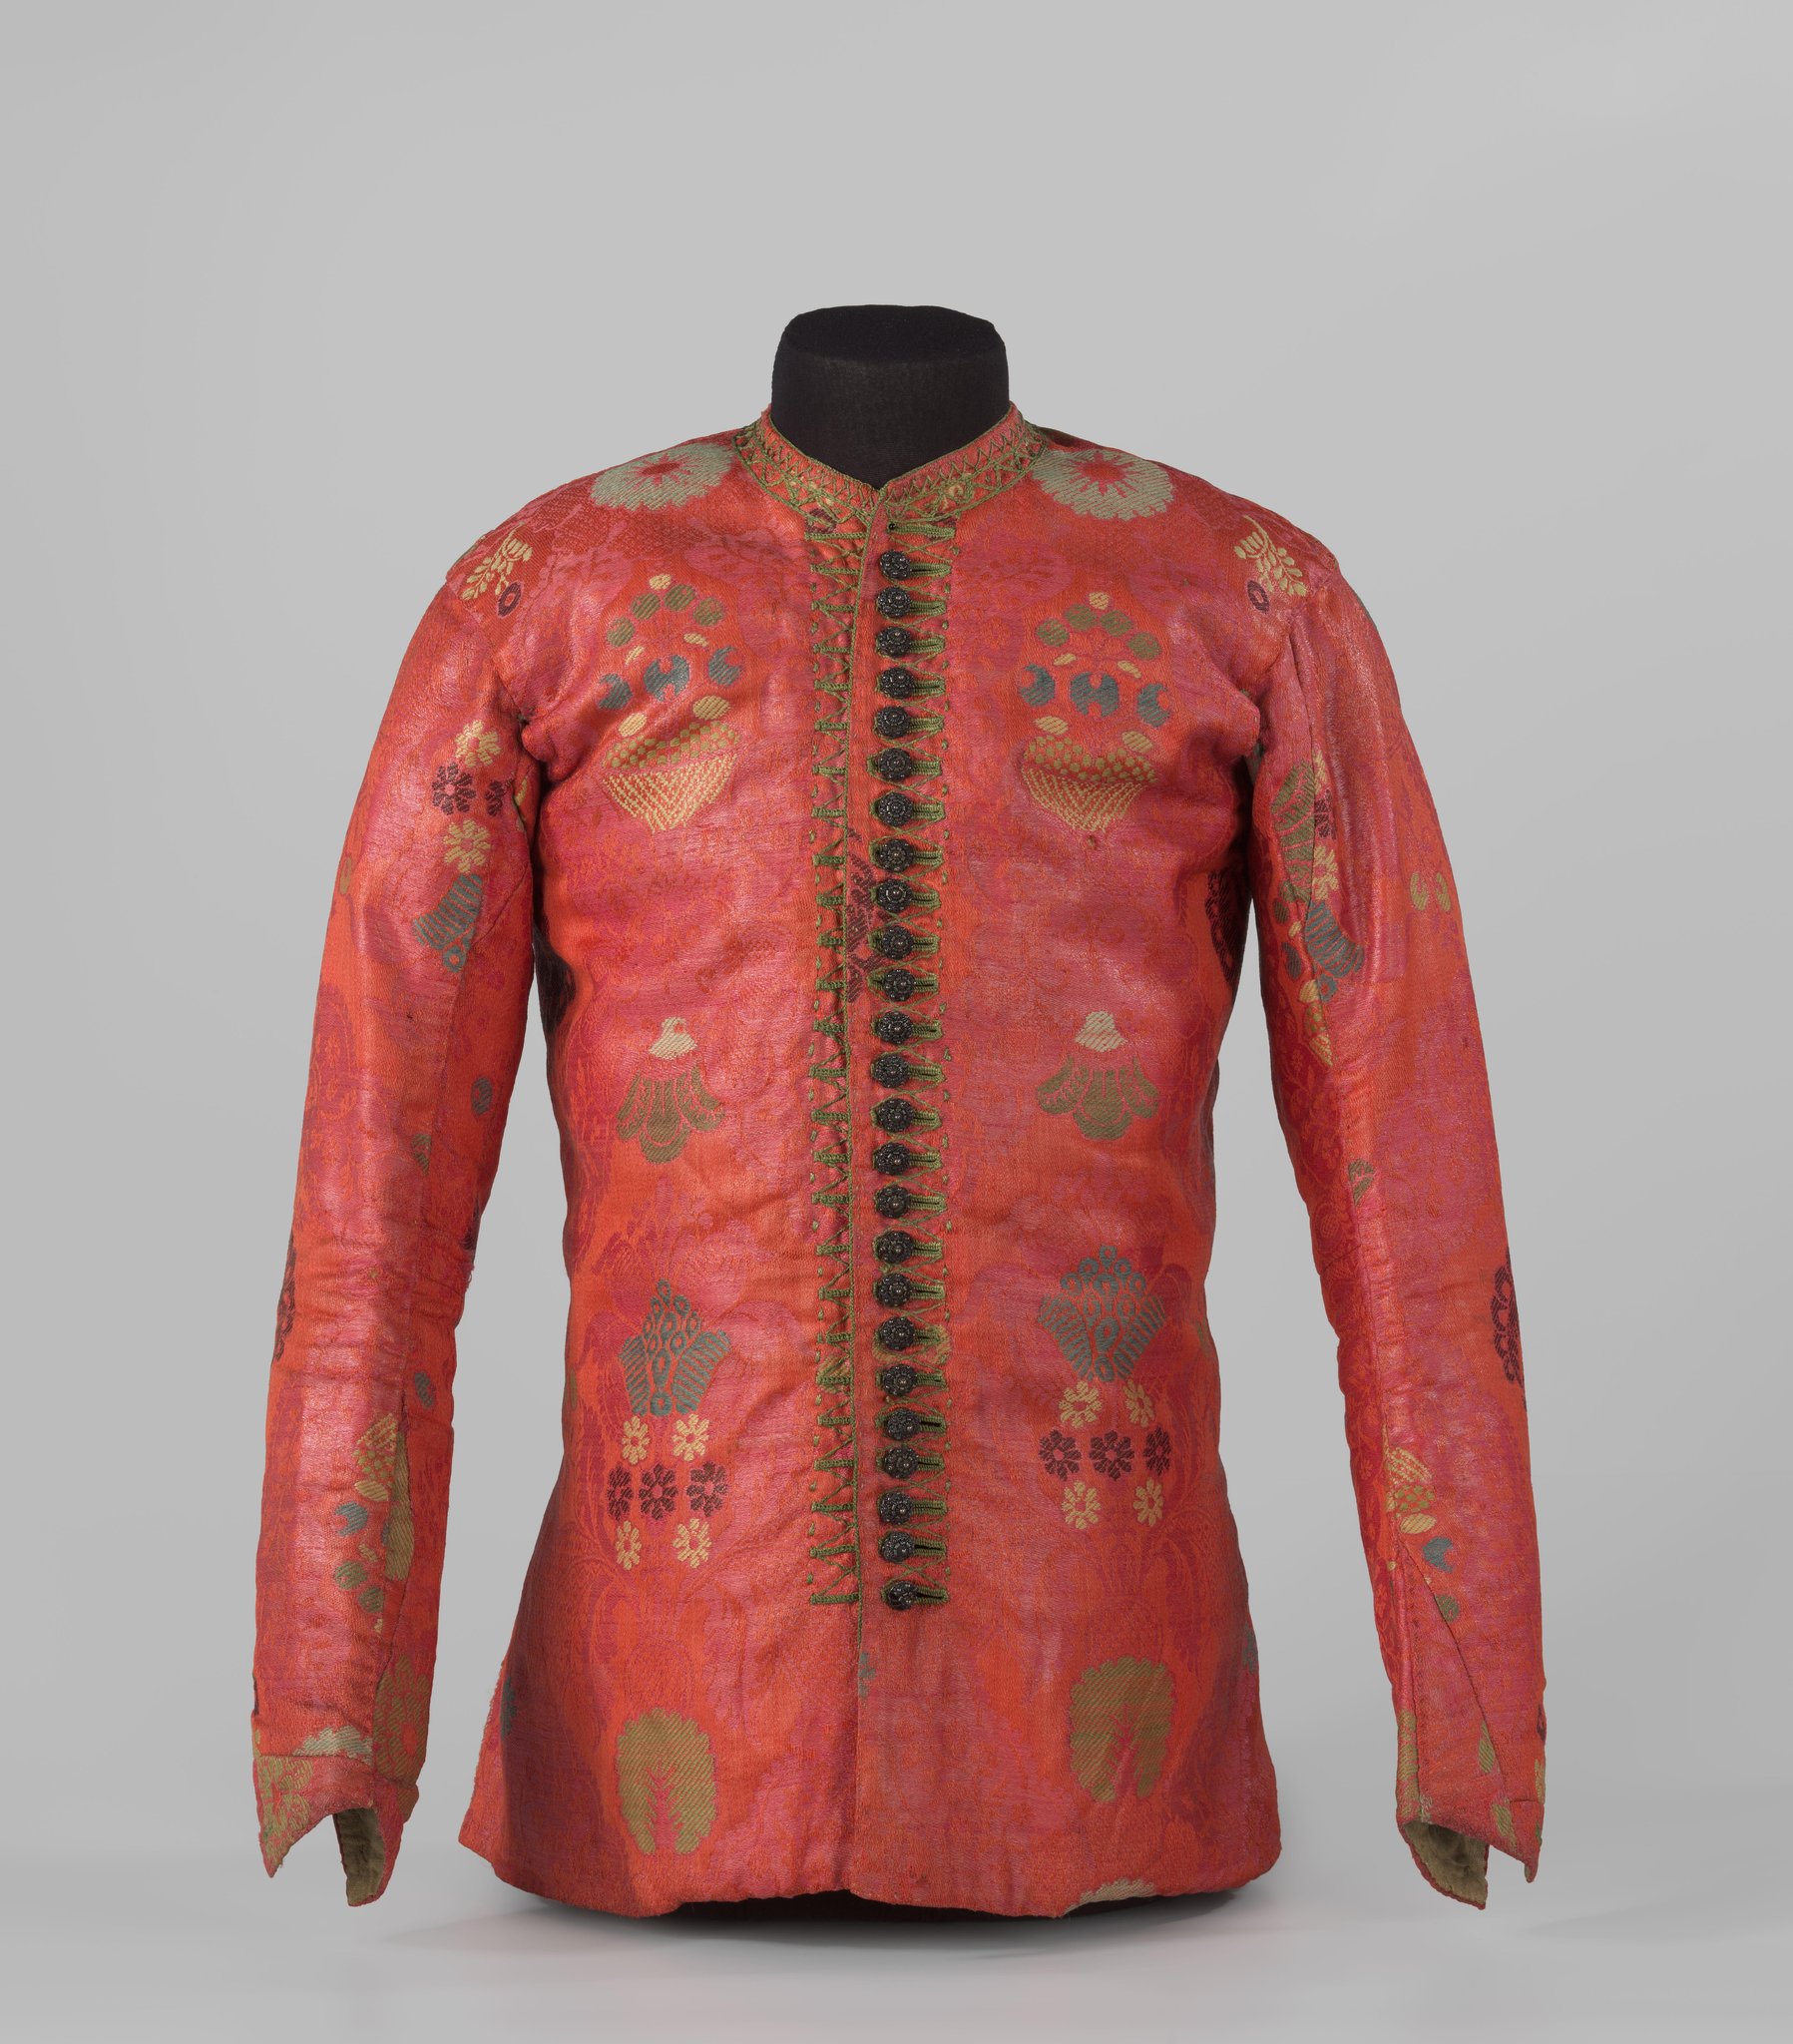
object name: main garment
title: Korte, recht jas van roodroze zijdedamast met bloemmotieven in bruin en meerdere groentinten, met lange mouwen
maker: Anonymous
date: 1700-1800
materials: textile, metal, silk, silver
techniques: damask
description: Korte, recht jas van roodroze zijdedamast met bloemmotieven in bruin en meerdere groentinten, met lange mouwen die onder de oksels open zijn. Sluiting d.m.v. 25 metalen (zilveren?) knopen. Hemdrok of hemdrock.